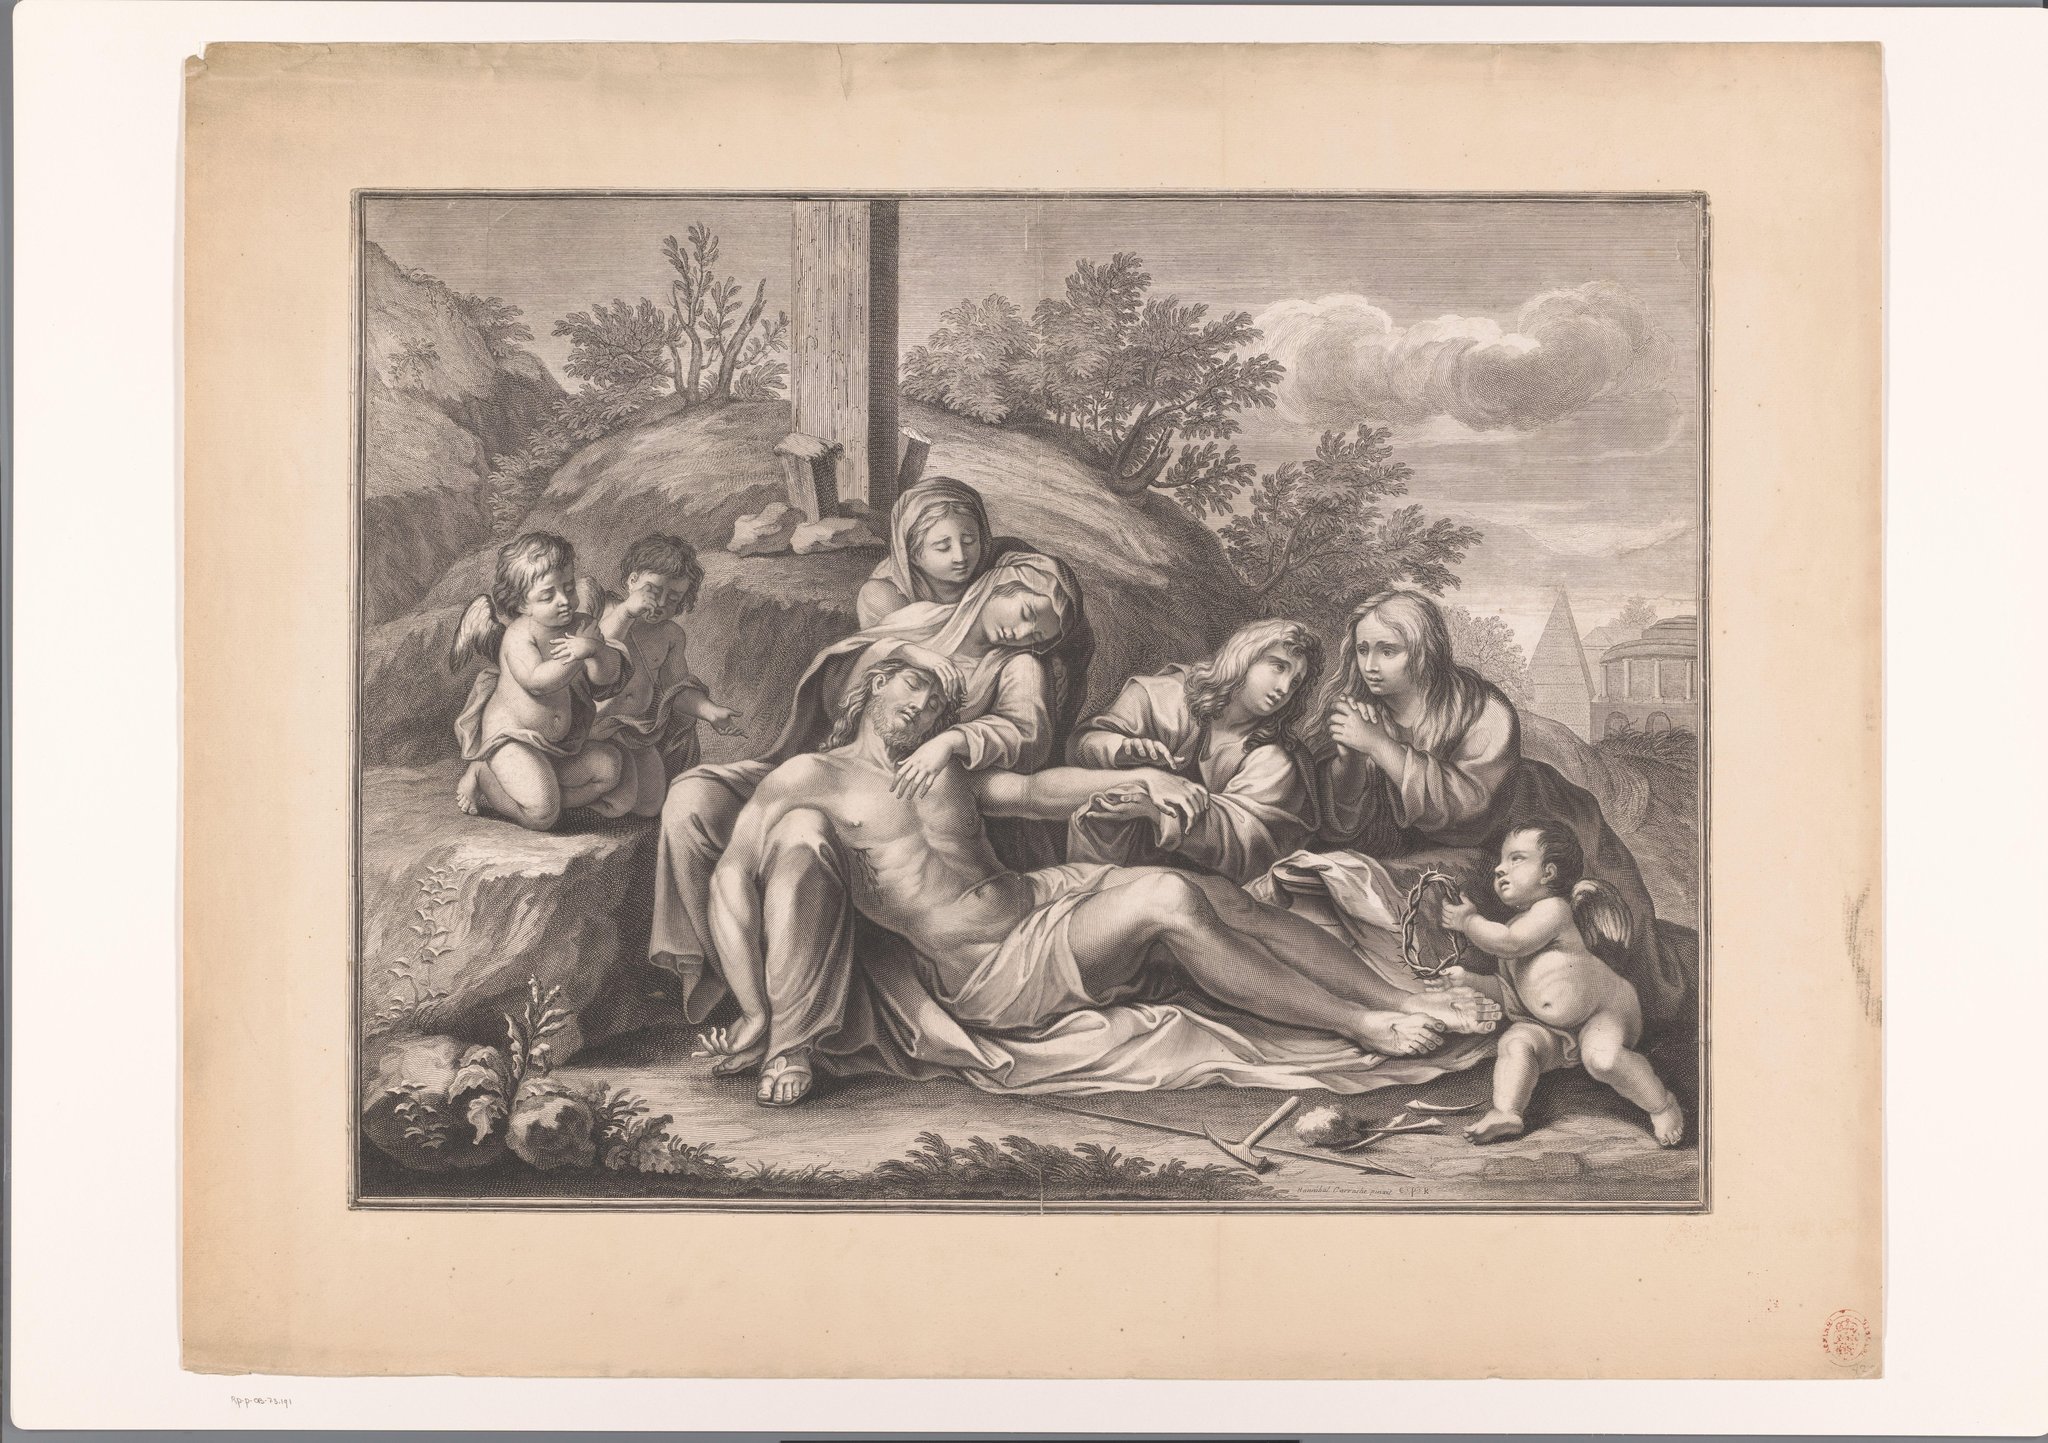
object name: print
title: Bewening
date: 1600-1699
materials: paper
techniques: engraving, etching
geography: italy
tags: lamentation over the dead christ by his relatives and friends (christ usually without crown of thorns)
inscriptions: collector's mark: Lugt 240